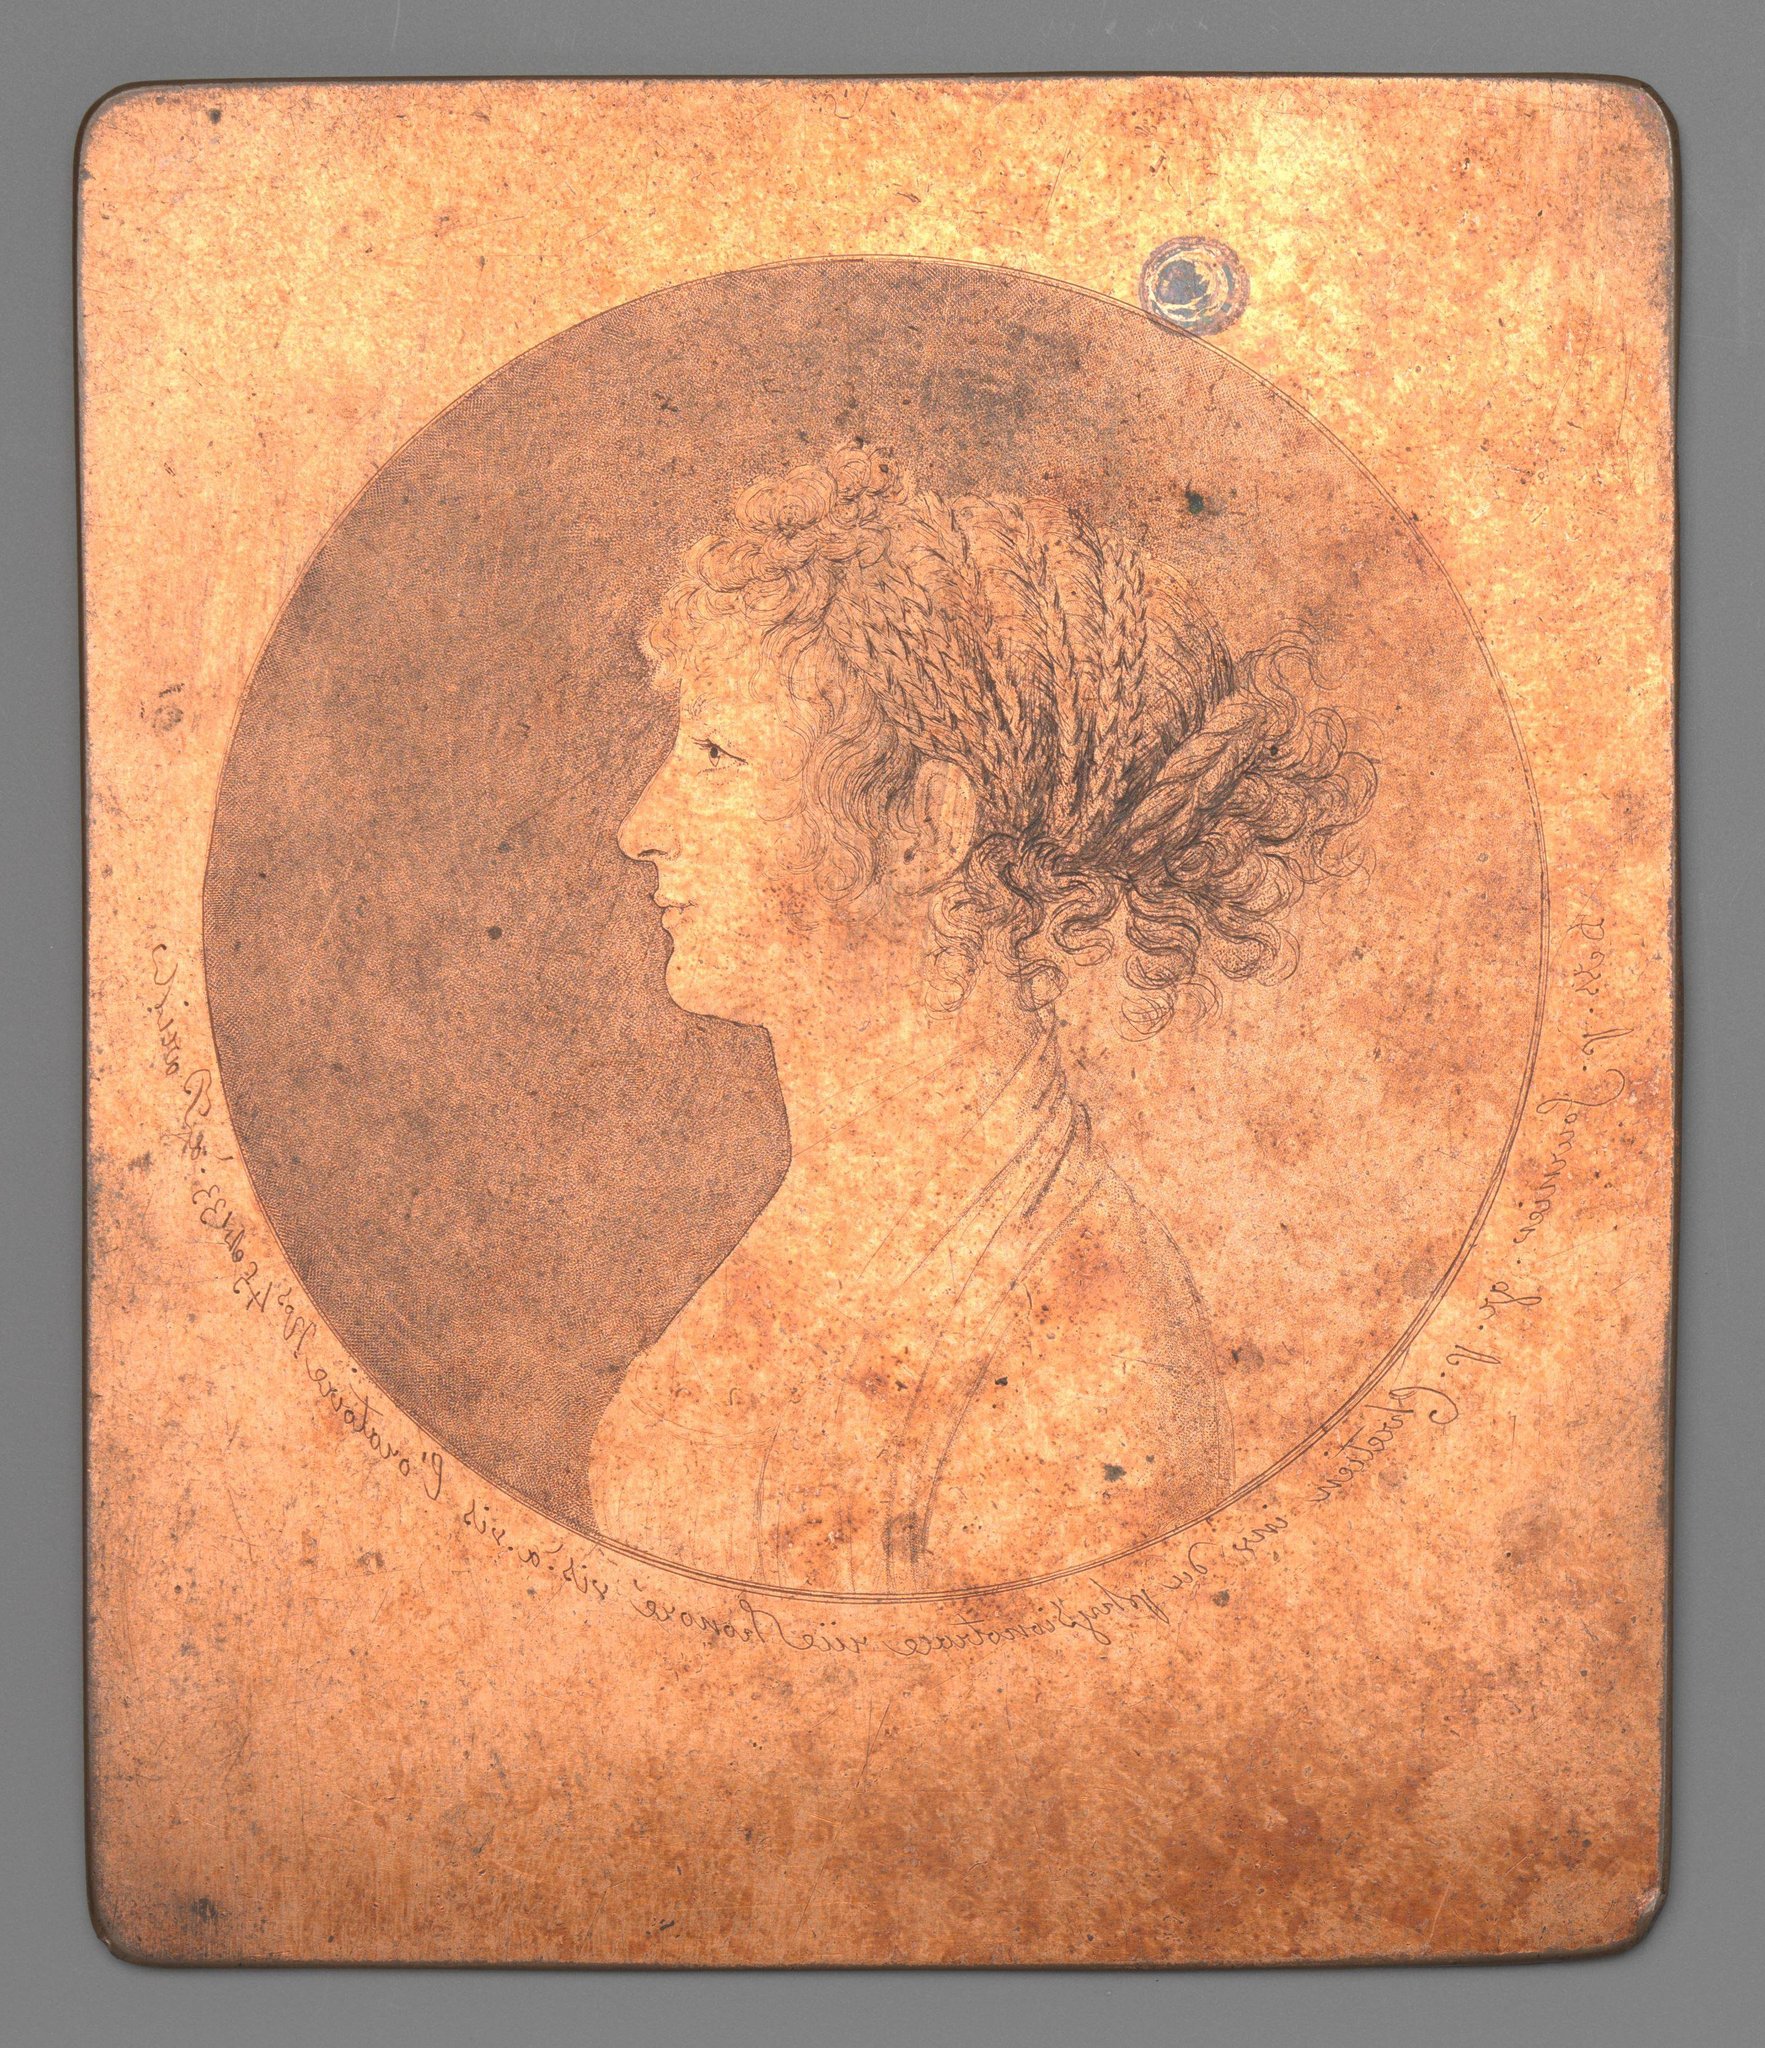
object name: copper plate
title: Portret van een vrouw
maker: gilles louis chrétien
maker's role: print maker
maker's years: 1754-1811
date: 1764-1811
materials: copper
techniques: aquatint